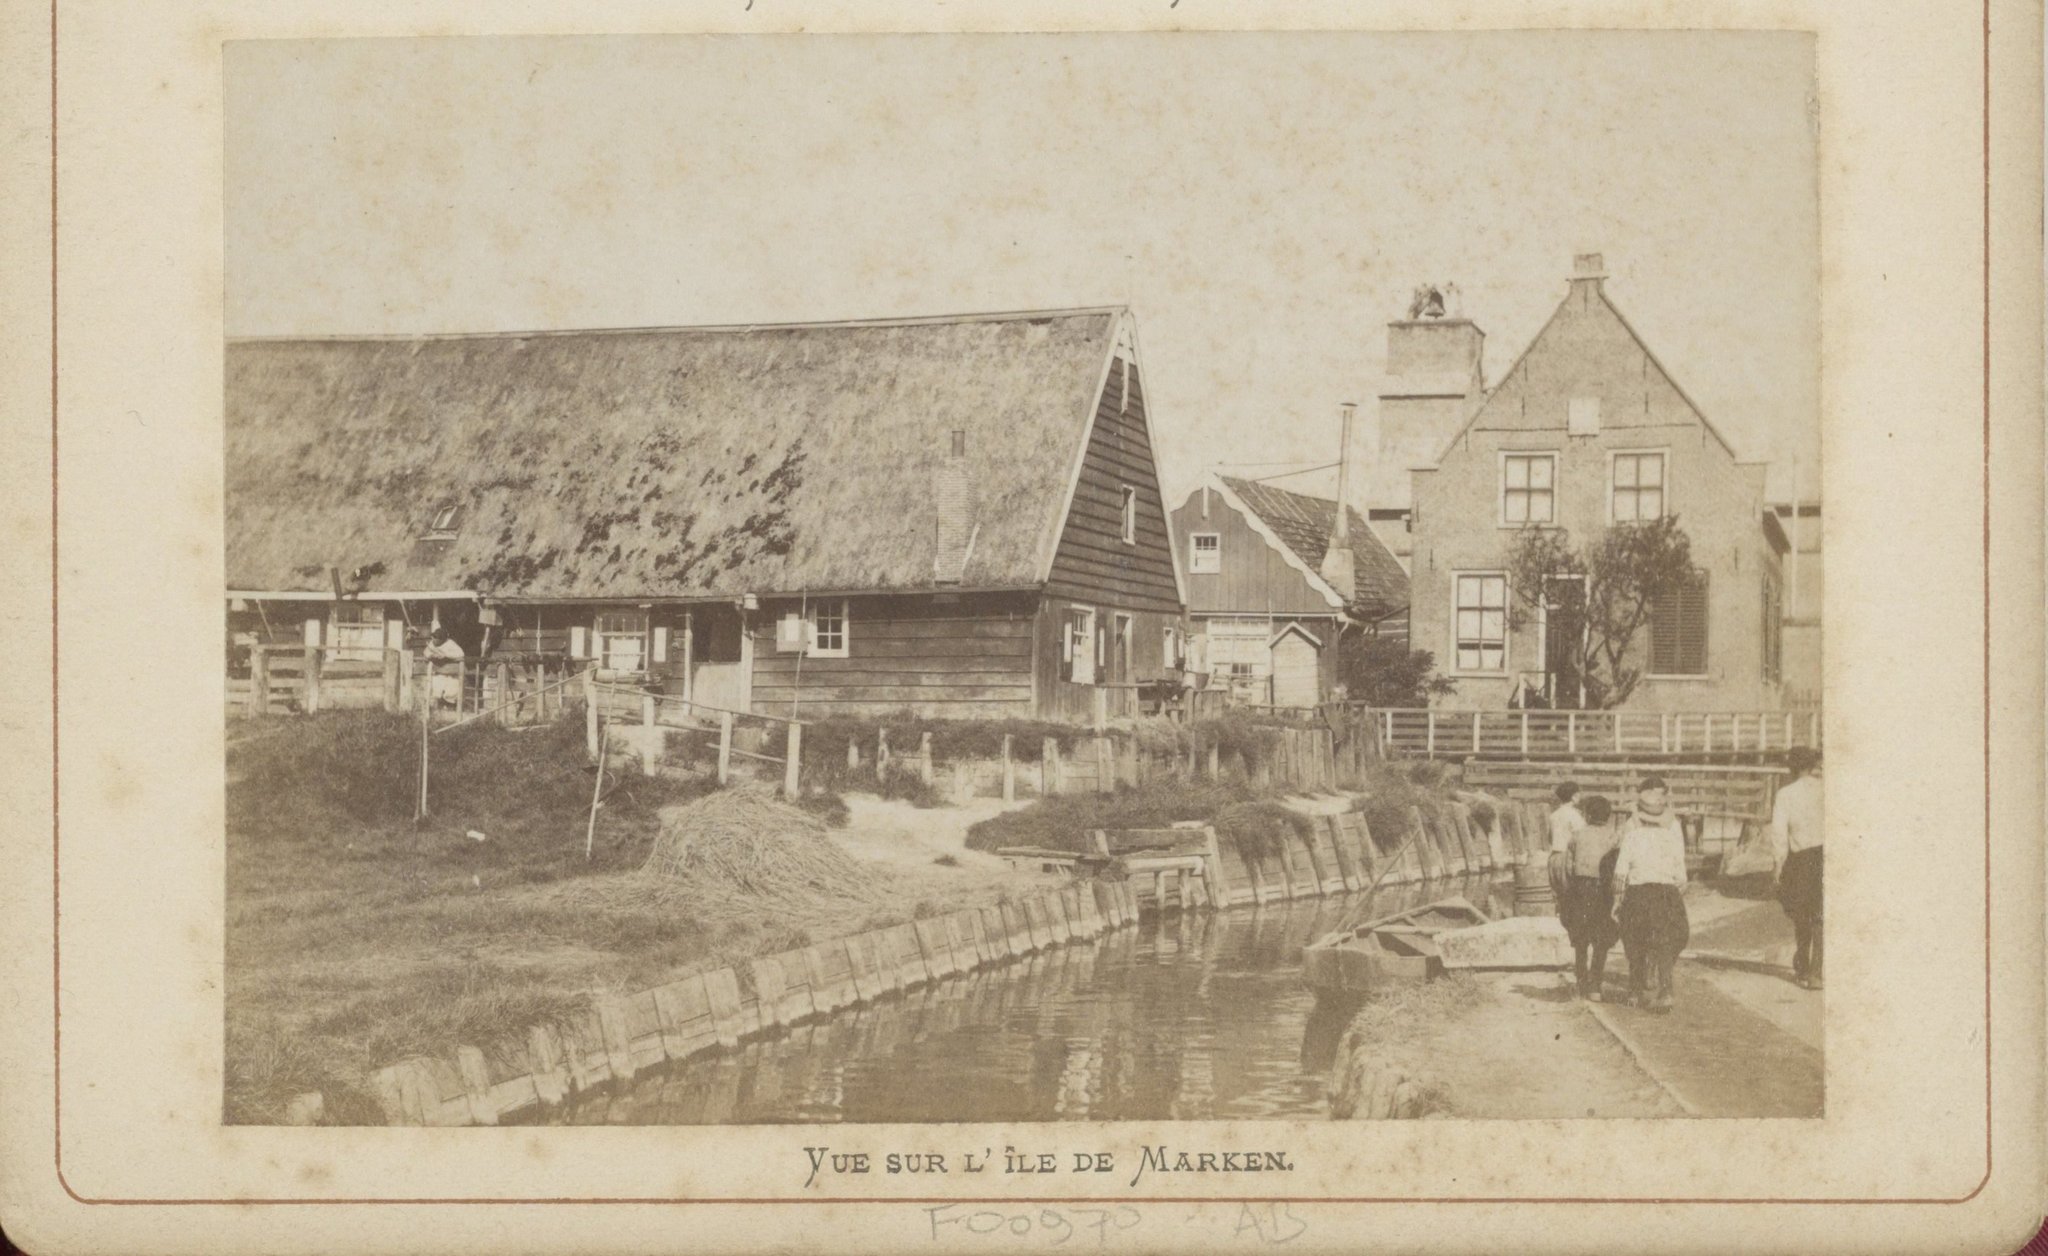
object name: photograph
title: Gezicht op huizen aan een sloot in Marken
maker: andries jager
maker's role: publisher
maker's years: 1825-1905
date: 1875-1910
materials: cardboard, paper, photographic support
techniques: albumen print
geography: marken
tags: village street, exterior ~ representation of a building, small canal, ditch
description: Onderdeel van Leporelloalbum met 28 foto's van Amsterdam en omstreken.